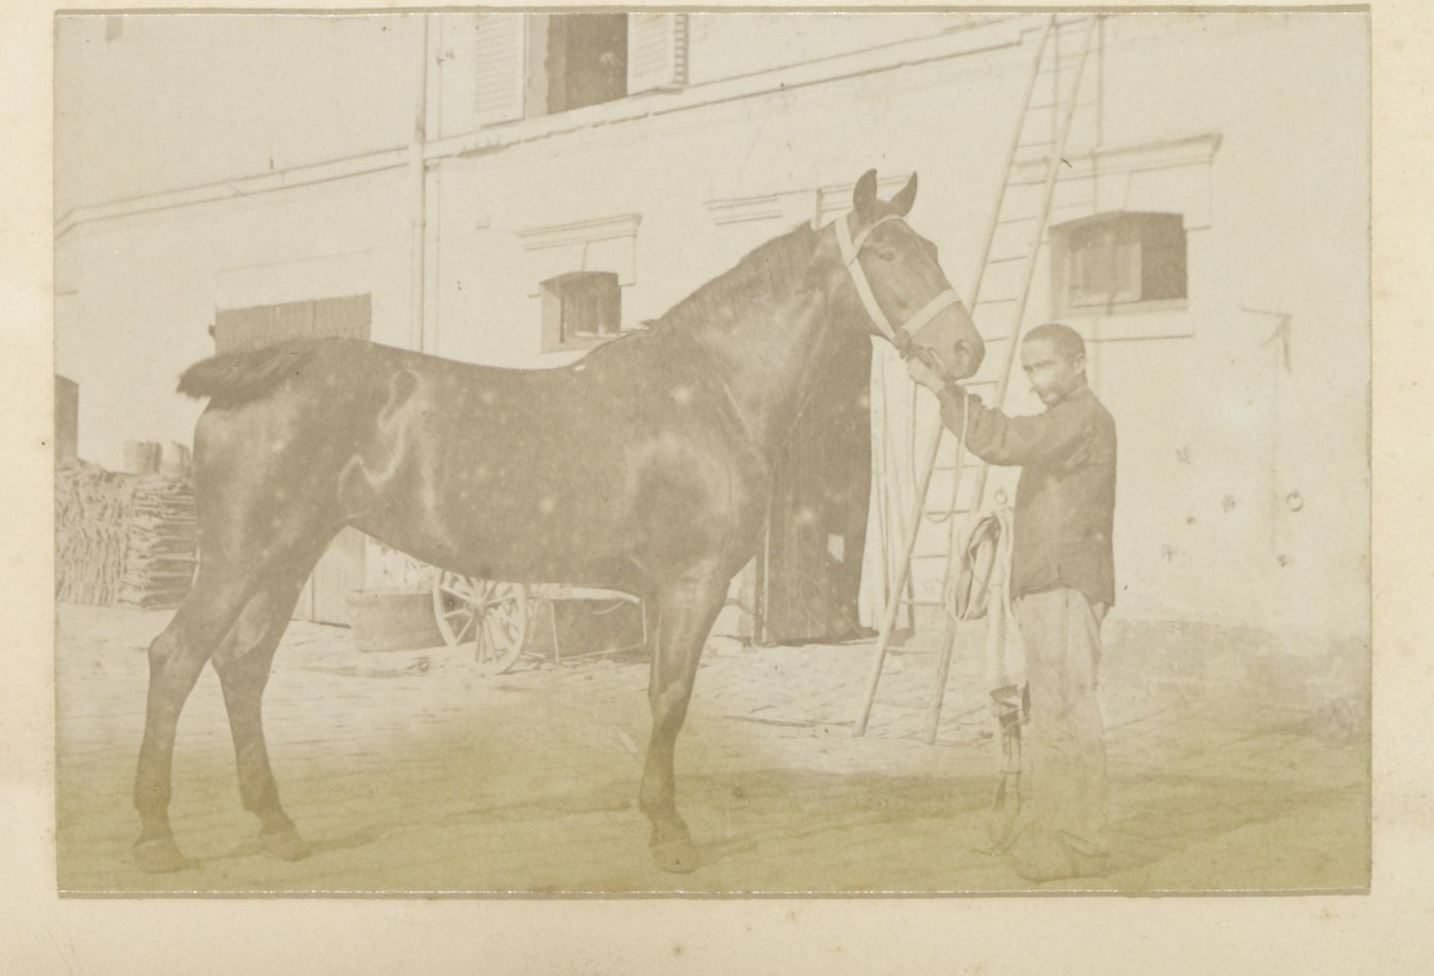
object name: photograph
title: Man houdt paard bij de teugels bij een koetshuis in Frankrijk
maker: Anonymous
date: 1900-1910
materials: paper, photographic support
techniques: albumen print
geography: france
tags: coach-house, horse, france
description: Onderdeel van Fotoalbum van een Franse amateurfotograaf met opnames van een familie, distilleerderij Delizy & Doistau Fils, het leger en bezienswaardigheden in Frankrijk.